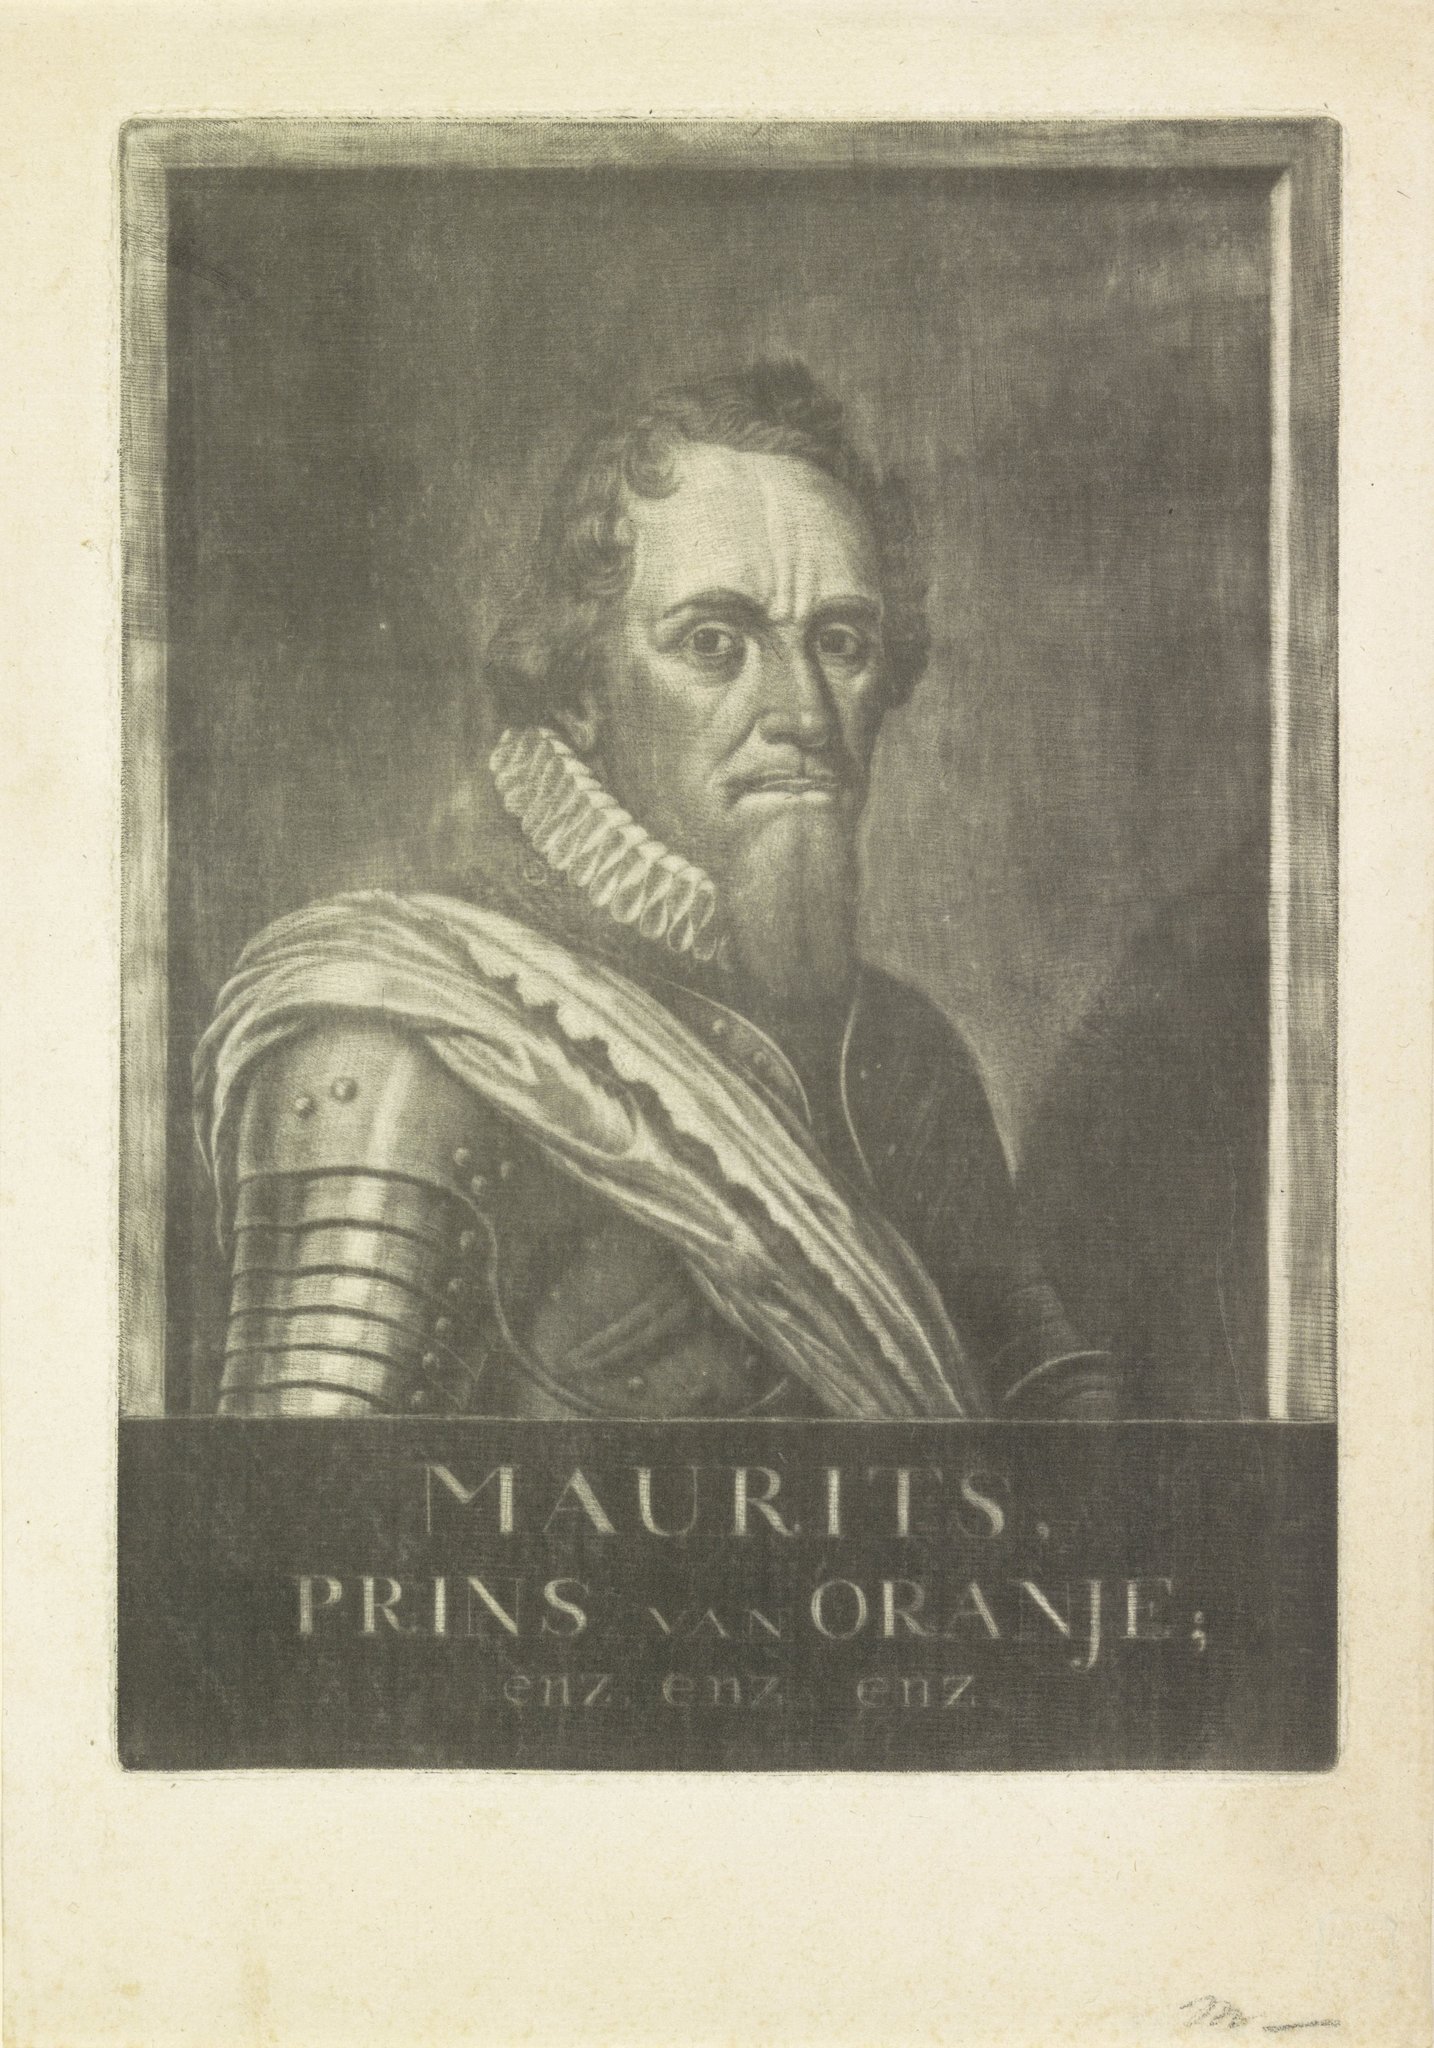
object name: print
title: Portret van Maurits, prins van Oranje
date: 1770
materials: paper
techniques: mezzotint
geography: leeuwarden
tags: the hague, maurice (prince of orange)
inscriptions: collector's mark: Lugt 963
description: De hier vermelde titel verwijst naar de hoogst verkregen titel van de geportretteerde, niet per se naar de titel die de geportretteerde op deze voorstelling draagt. Prent uit: Bosch, Johannes van den. De heeren stadhouderen van Vriesland, zedert den jare acht-hondert, volgens hoogst derzelver successie kortelyk beschreven. Leeuwarden: Abraham Ferwerda en Gerrit Tresling, 1770.